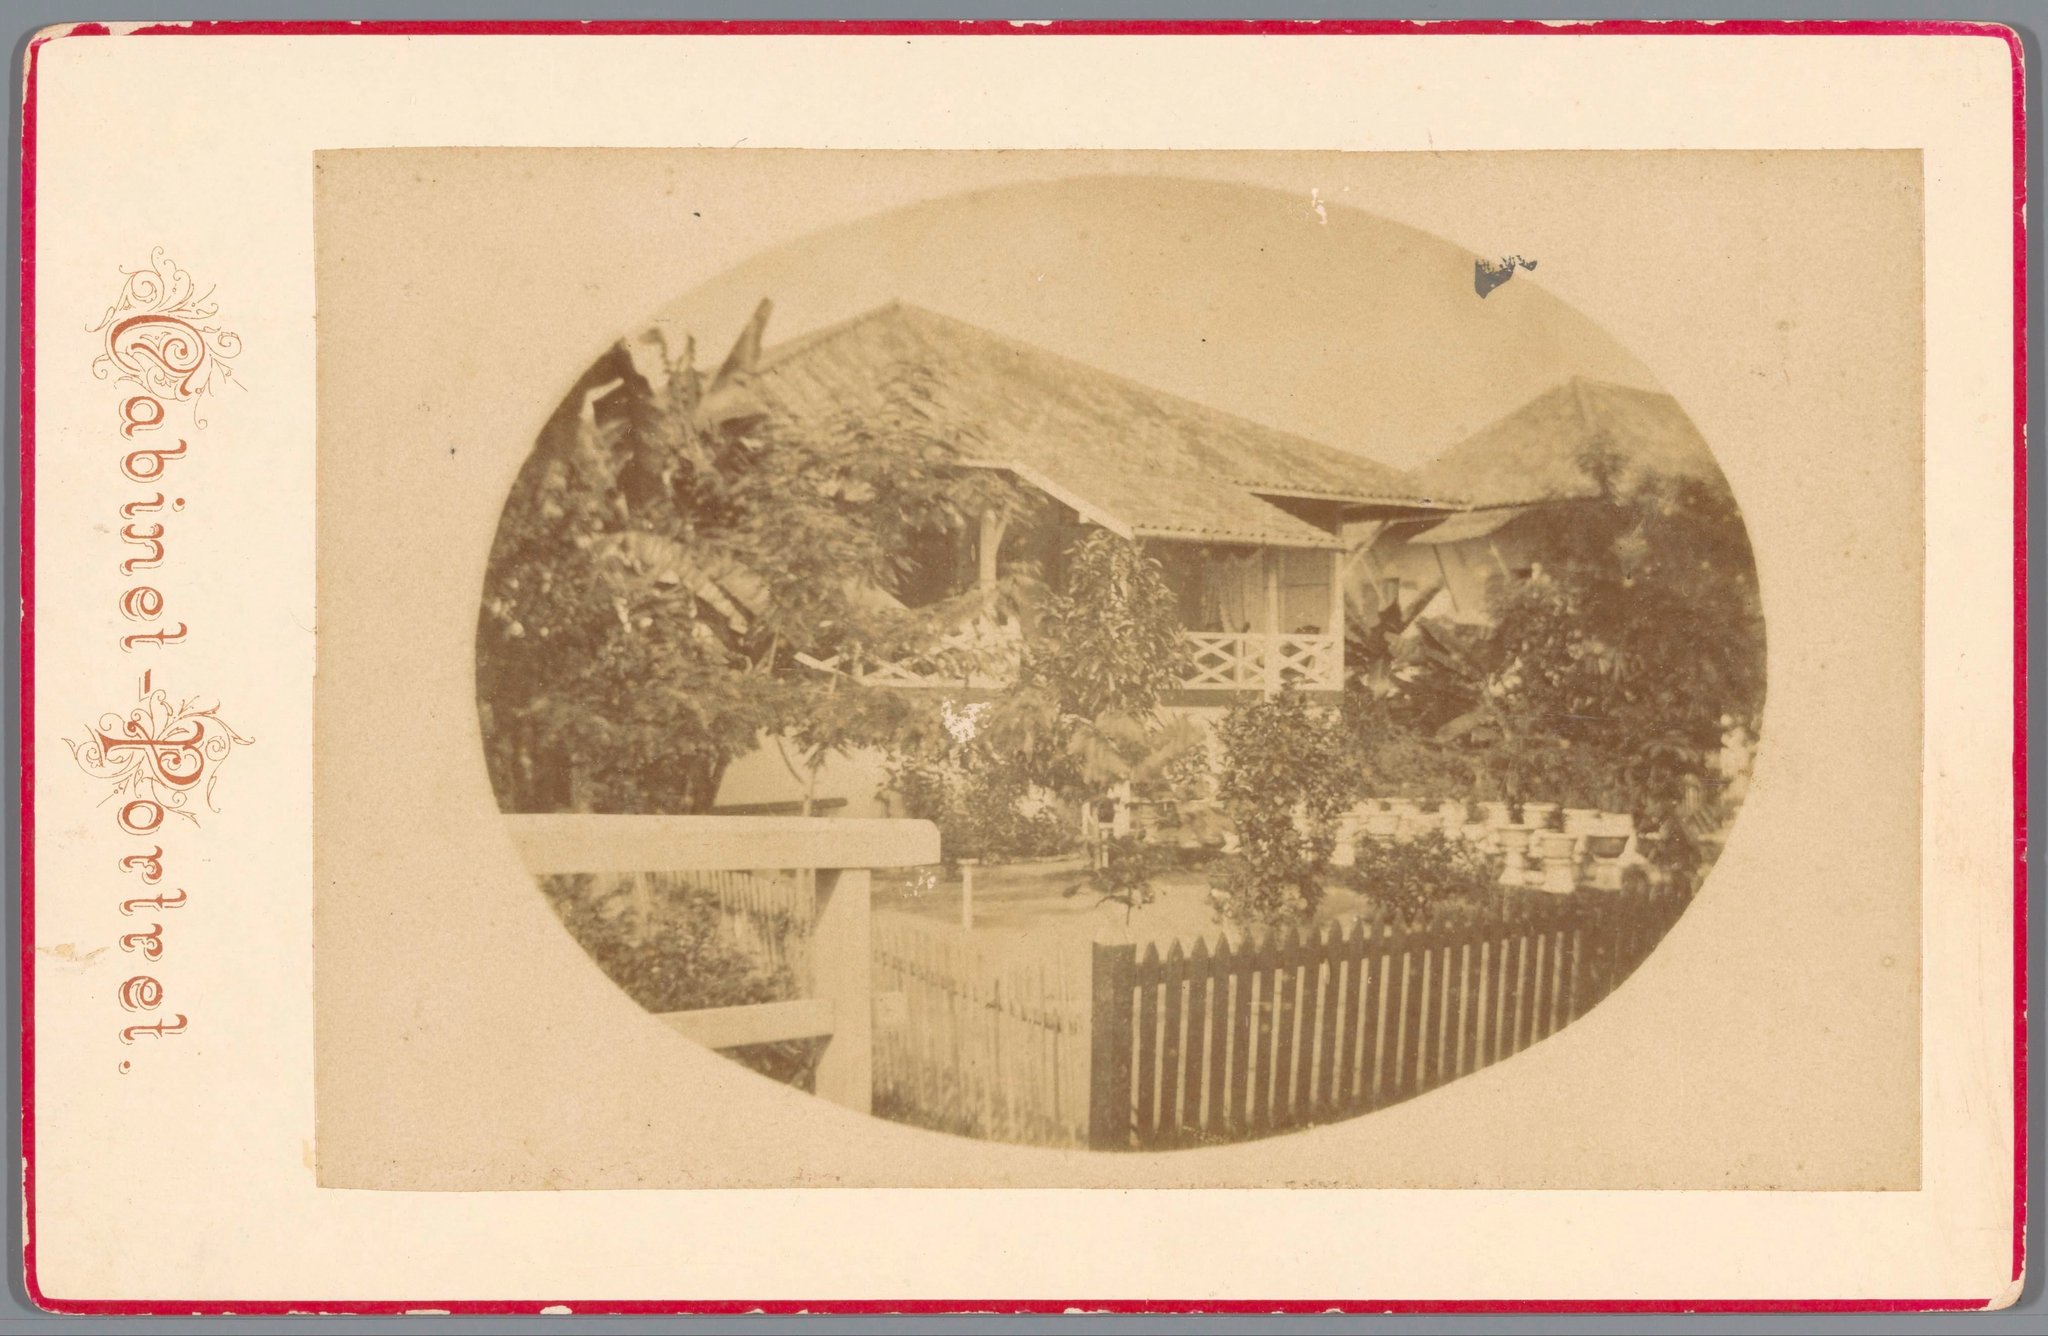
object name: cabinet photograph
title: Huis met een tuin, bewoond door mr. Margadant, Palembang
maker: Anonymous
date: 1890-1910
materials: cardboard, paper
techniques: albumen print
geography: palembang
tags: garden, loggia, verandah, porch, palembang (city)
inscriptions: inscription: ‘Cabinet-Portret’, inscription: ‘In en dergelijk huis woonden Lucie en ik van/ Nov. 1879-Mei 1882’